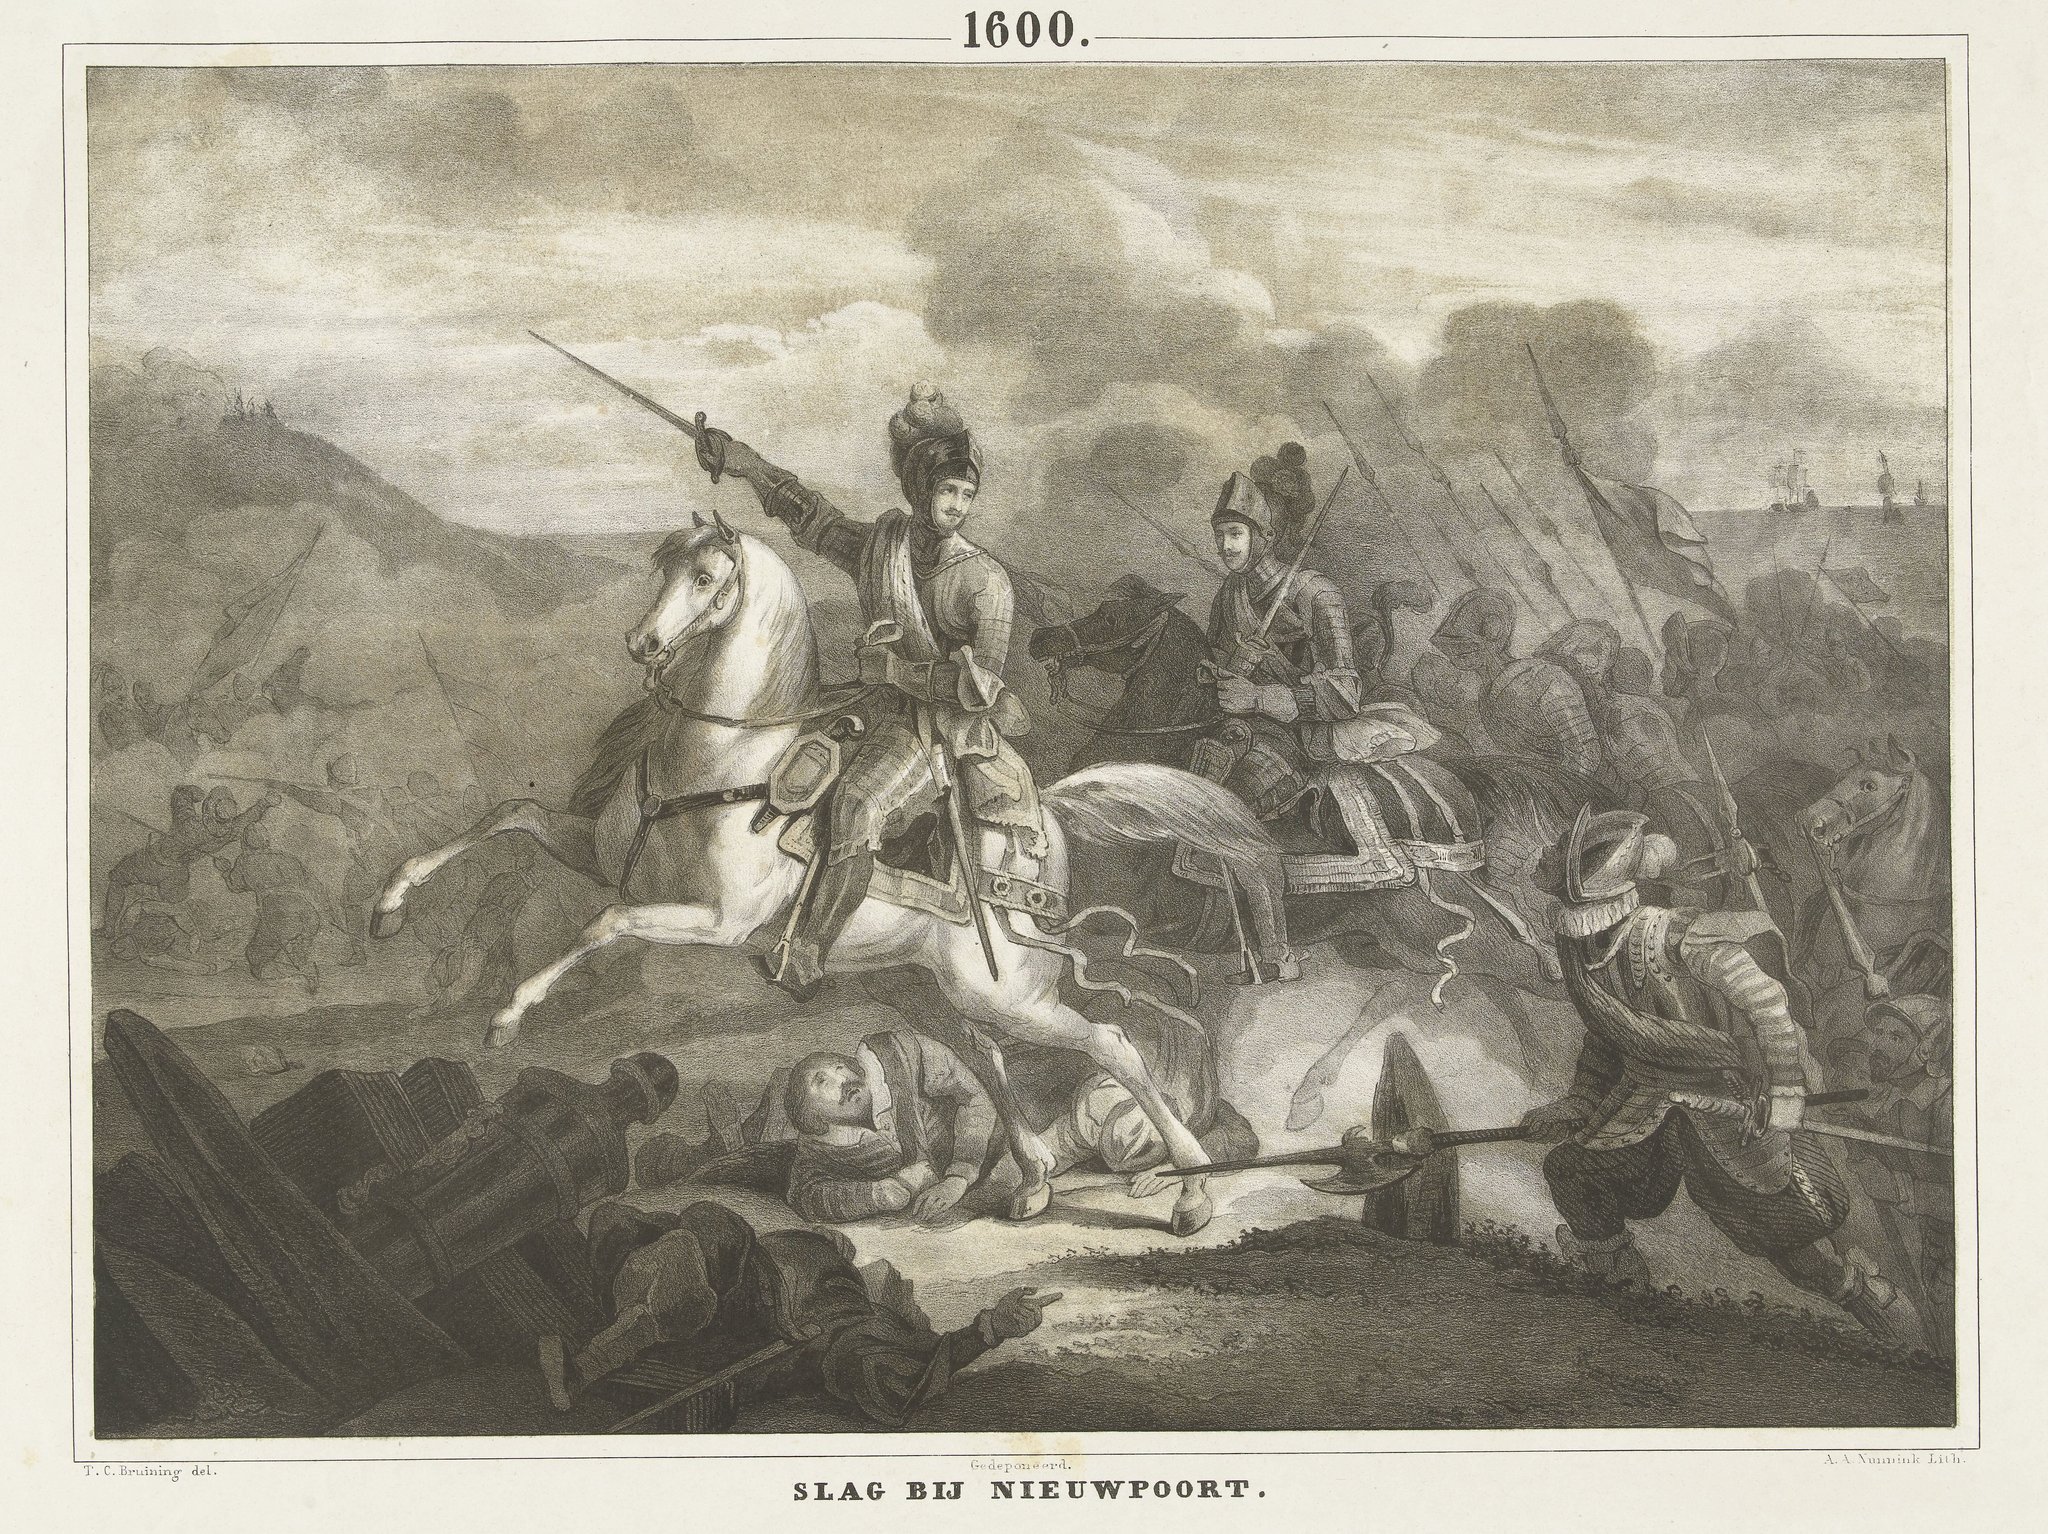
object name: history print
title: Slag bij Nieuwpoort, 1600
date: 1853-1855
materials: paper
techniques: tone lithography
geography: netherlands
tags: the hague, maurice (prince of orange), brussels, albrecht aartshertog van oostenrijk, battle (+ land forces), battle of nieuwpoort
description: Gebruikt als illustratie in: J.H. Eichman & H. Altmann, Vaderlandsche historieplaten voor scholen en huisgezinnen, Leiden, 1855. Dit nummer is een door het RPK toegevoegd nummer en staat niet in Frederik Muller, het werk waar de prent voor is gemaakt of uit afkomstig is, staat wel vermeld in Frederik Muller.